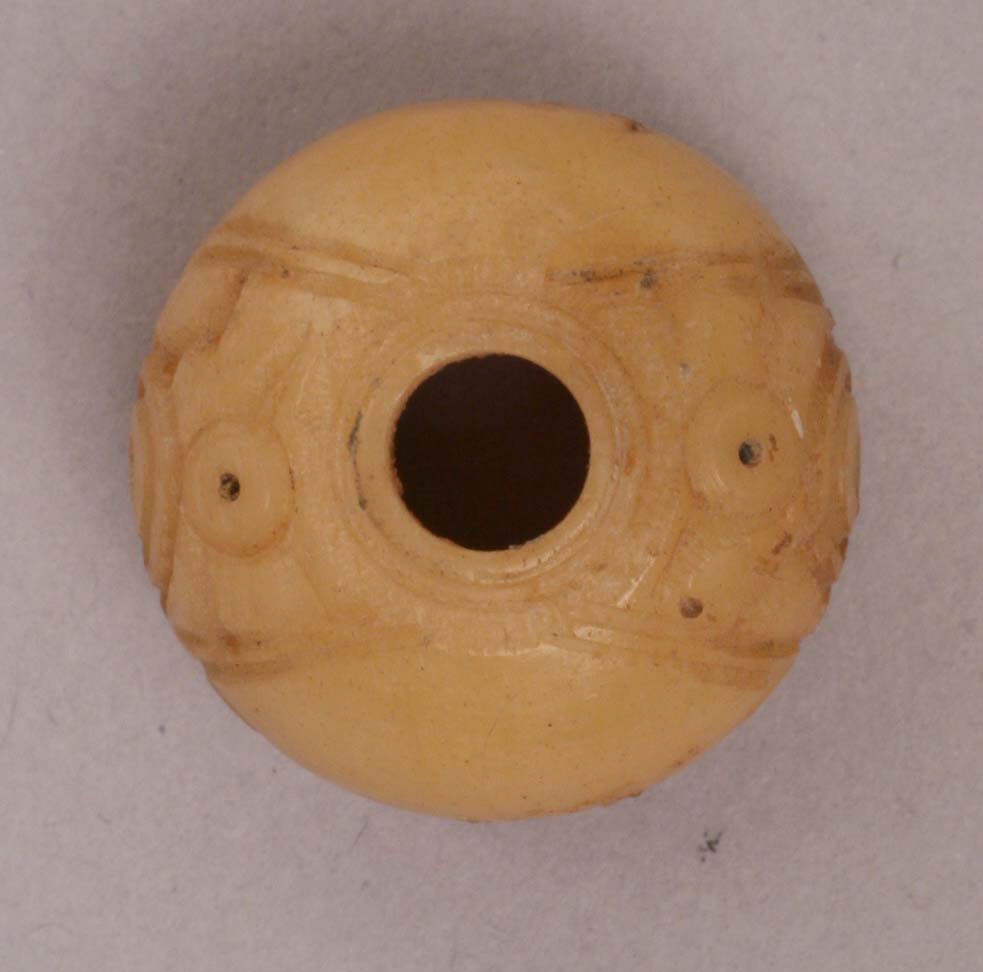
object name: button or bead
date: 801-1000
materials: bone, paint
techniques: incising, inlay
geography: iran